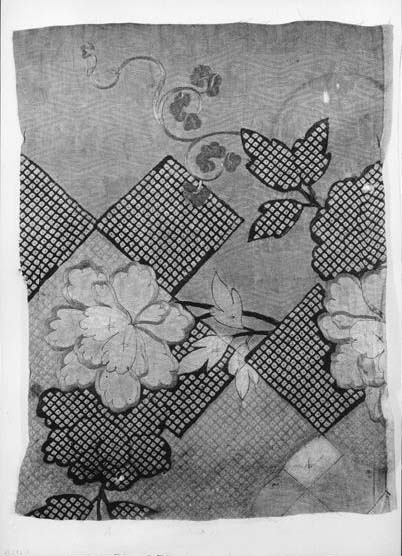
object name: piece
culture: japanese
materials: silk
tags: flowers,leaves